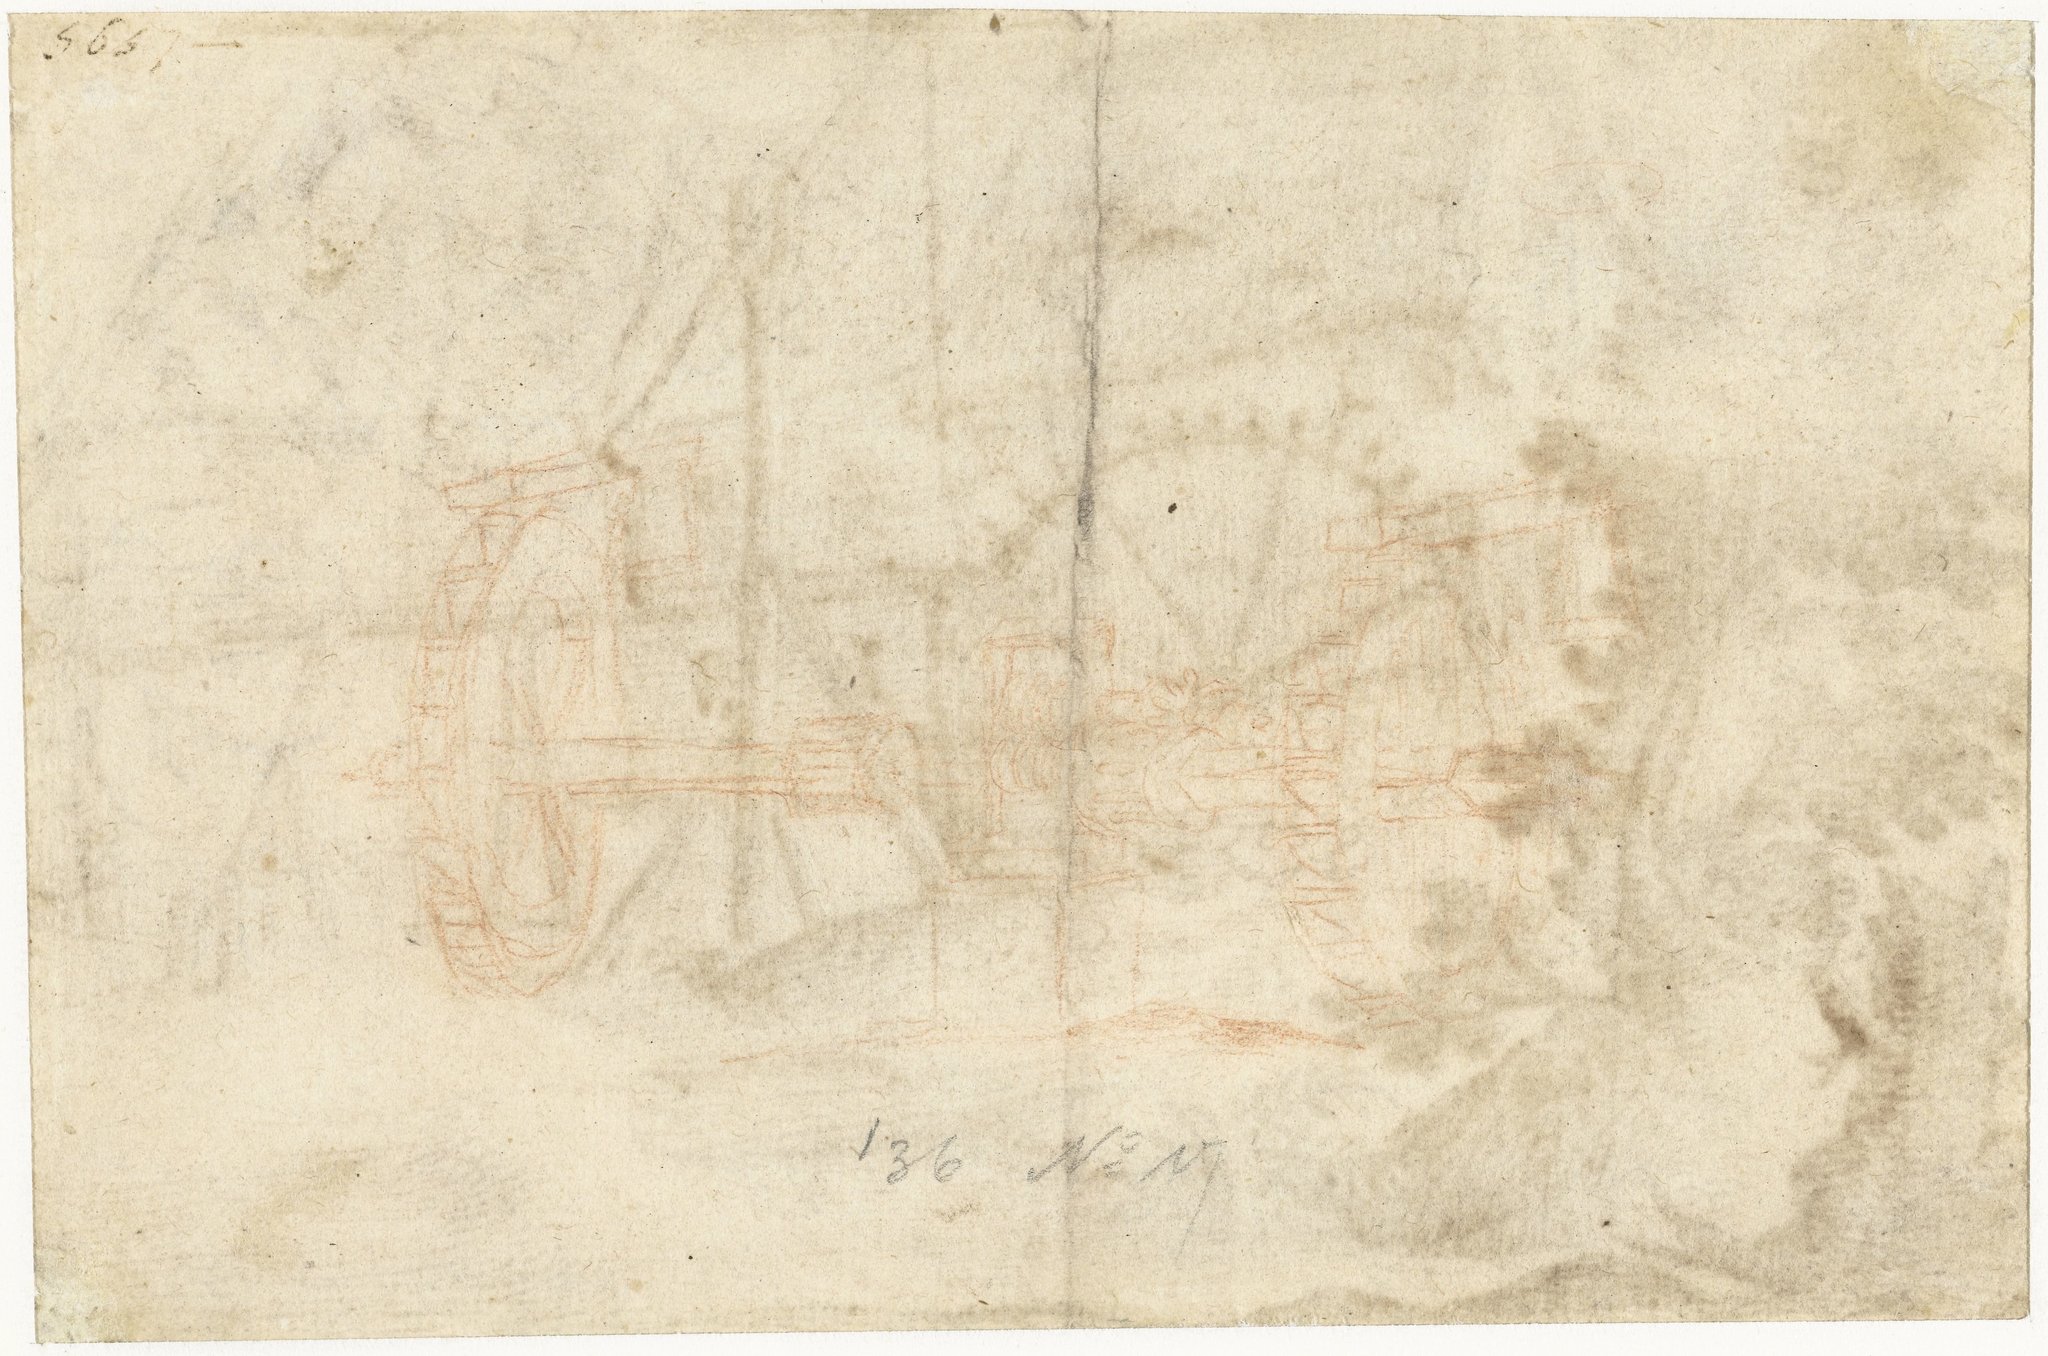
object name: drawing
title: De raderen van een watermolen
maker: Anonymous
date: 1600-1699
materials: chalk, paper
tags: watermill